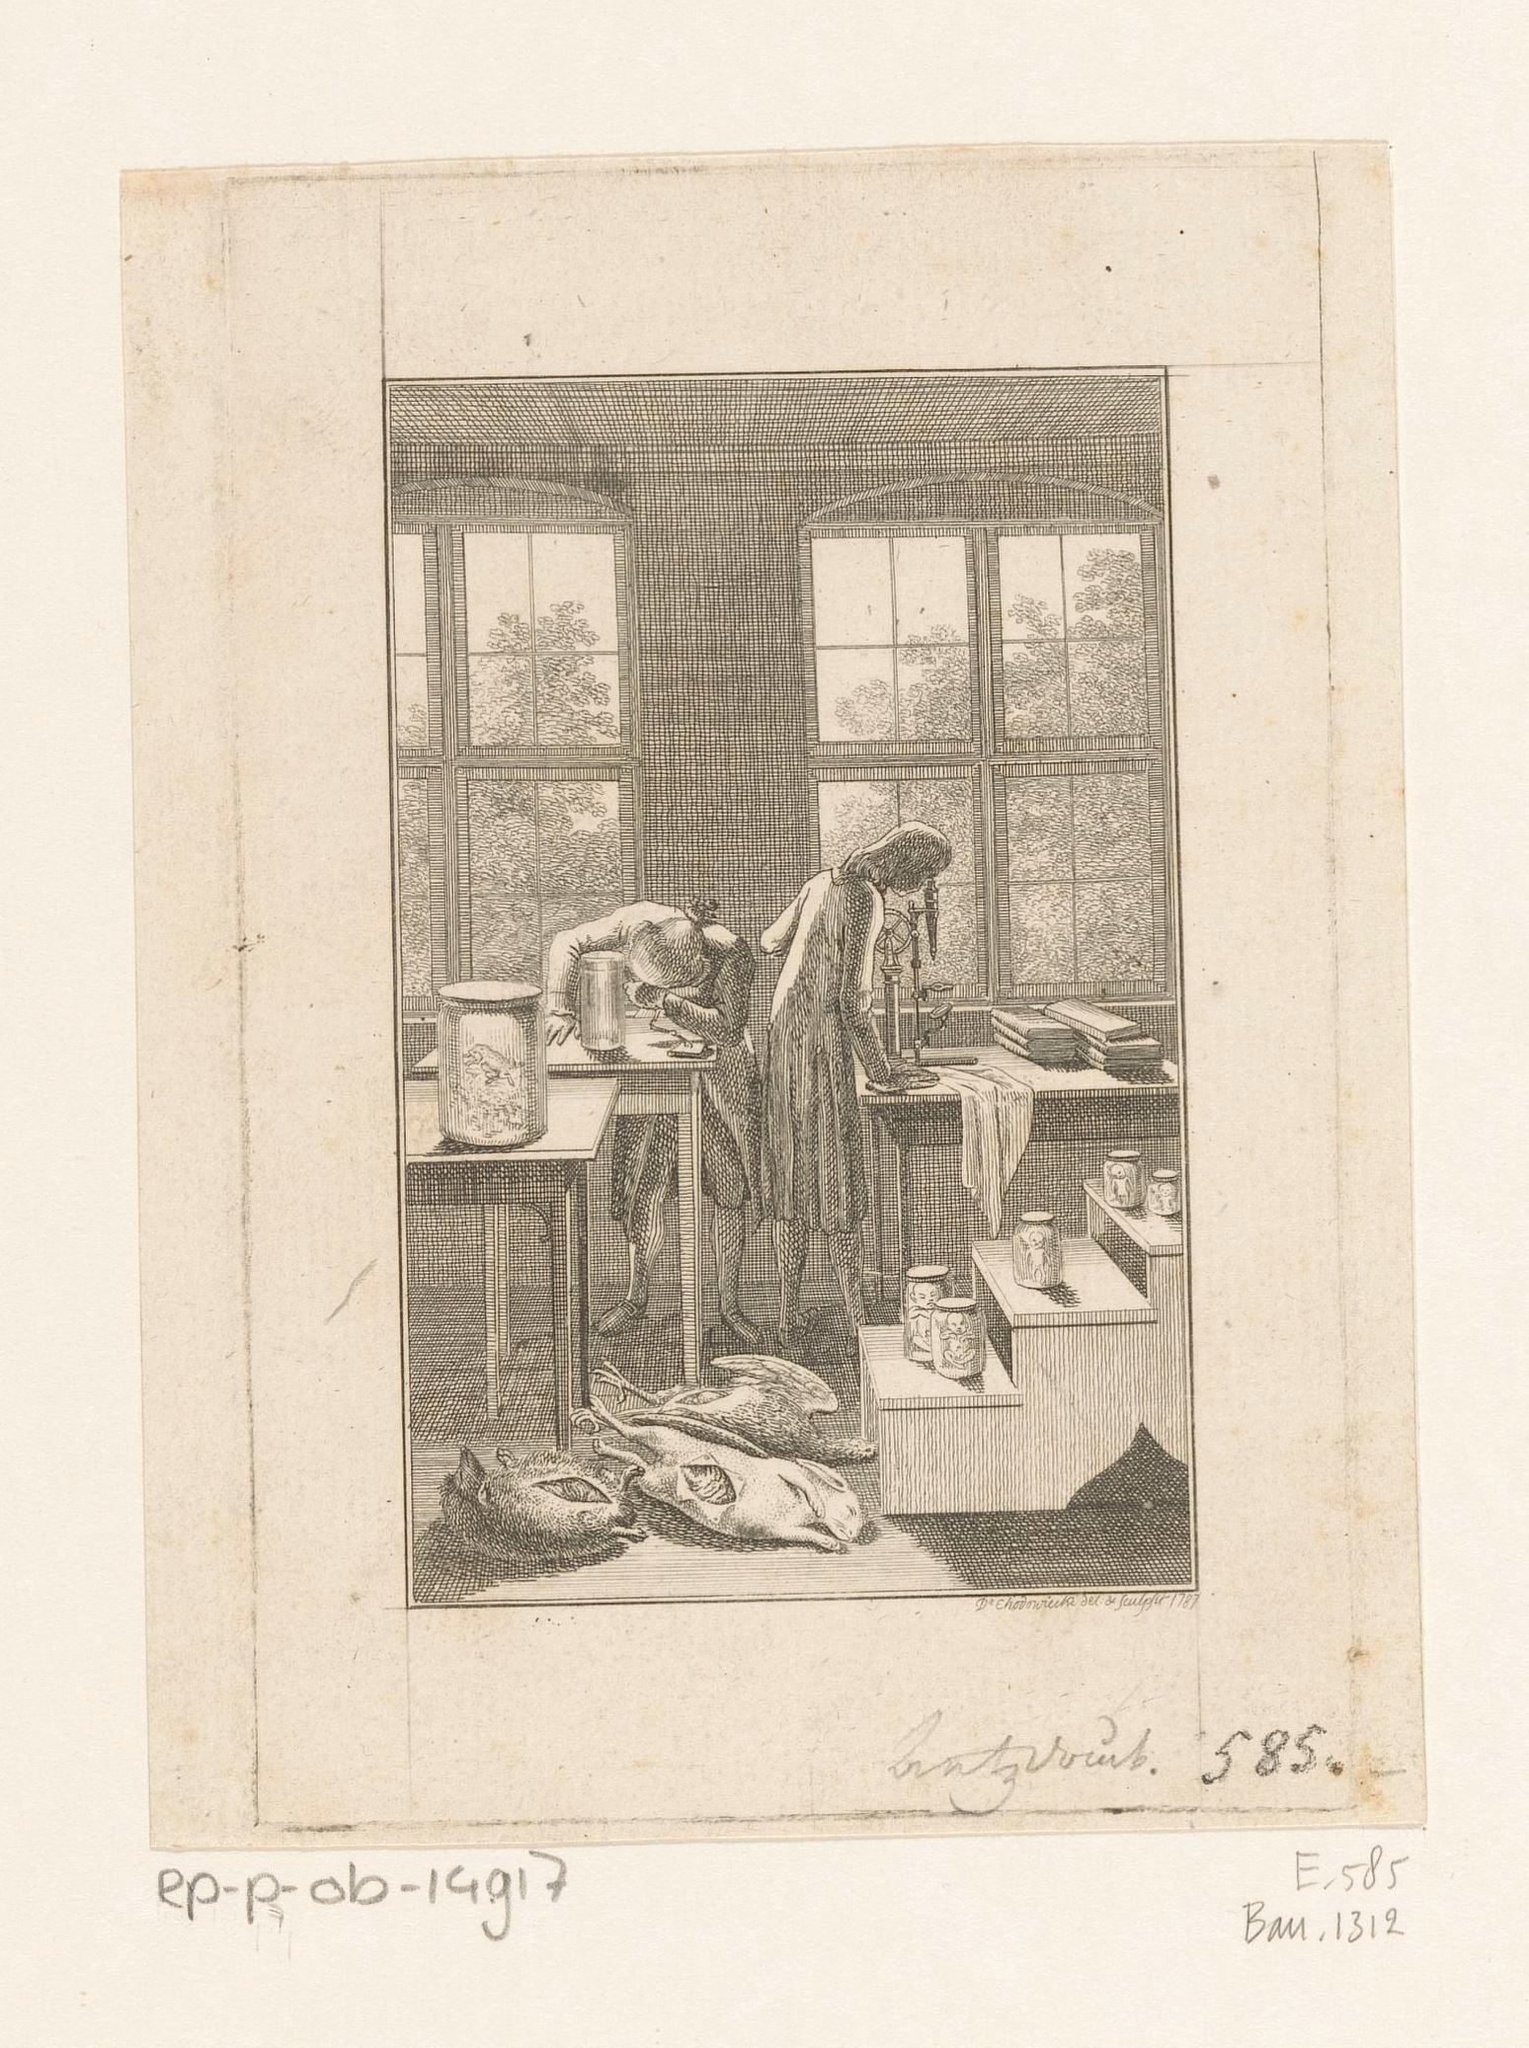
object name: print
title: Twee natuurkundigen, om hen heen ontlede dieren en baby's op sterkwater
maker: daniel nikolaus chodowiecki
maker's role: draughtsman, print maker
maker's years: 1726-1801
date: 1787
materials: paper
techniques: etching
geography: berlin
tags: physicist, physiology and anatomy (+ scholar, scientist (at work)), dissection, interior of the house, laboratory, research room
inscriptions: collector's mark: Lugt 2228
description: Volgens de beschikbare literatuur zou deze prent behoren tot 'Naturgeschichte' van Johann Friedrich Blumenbach, maar de daadwerkelijke publicatie wordt niet genoemd.